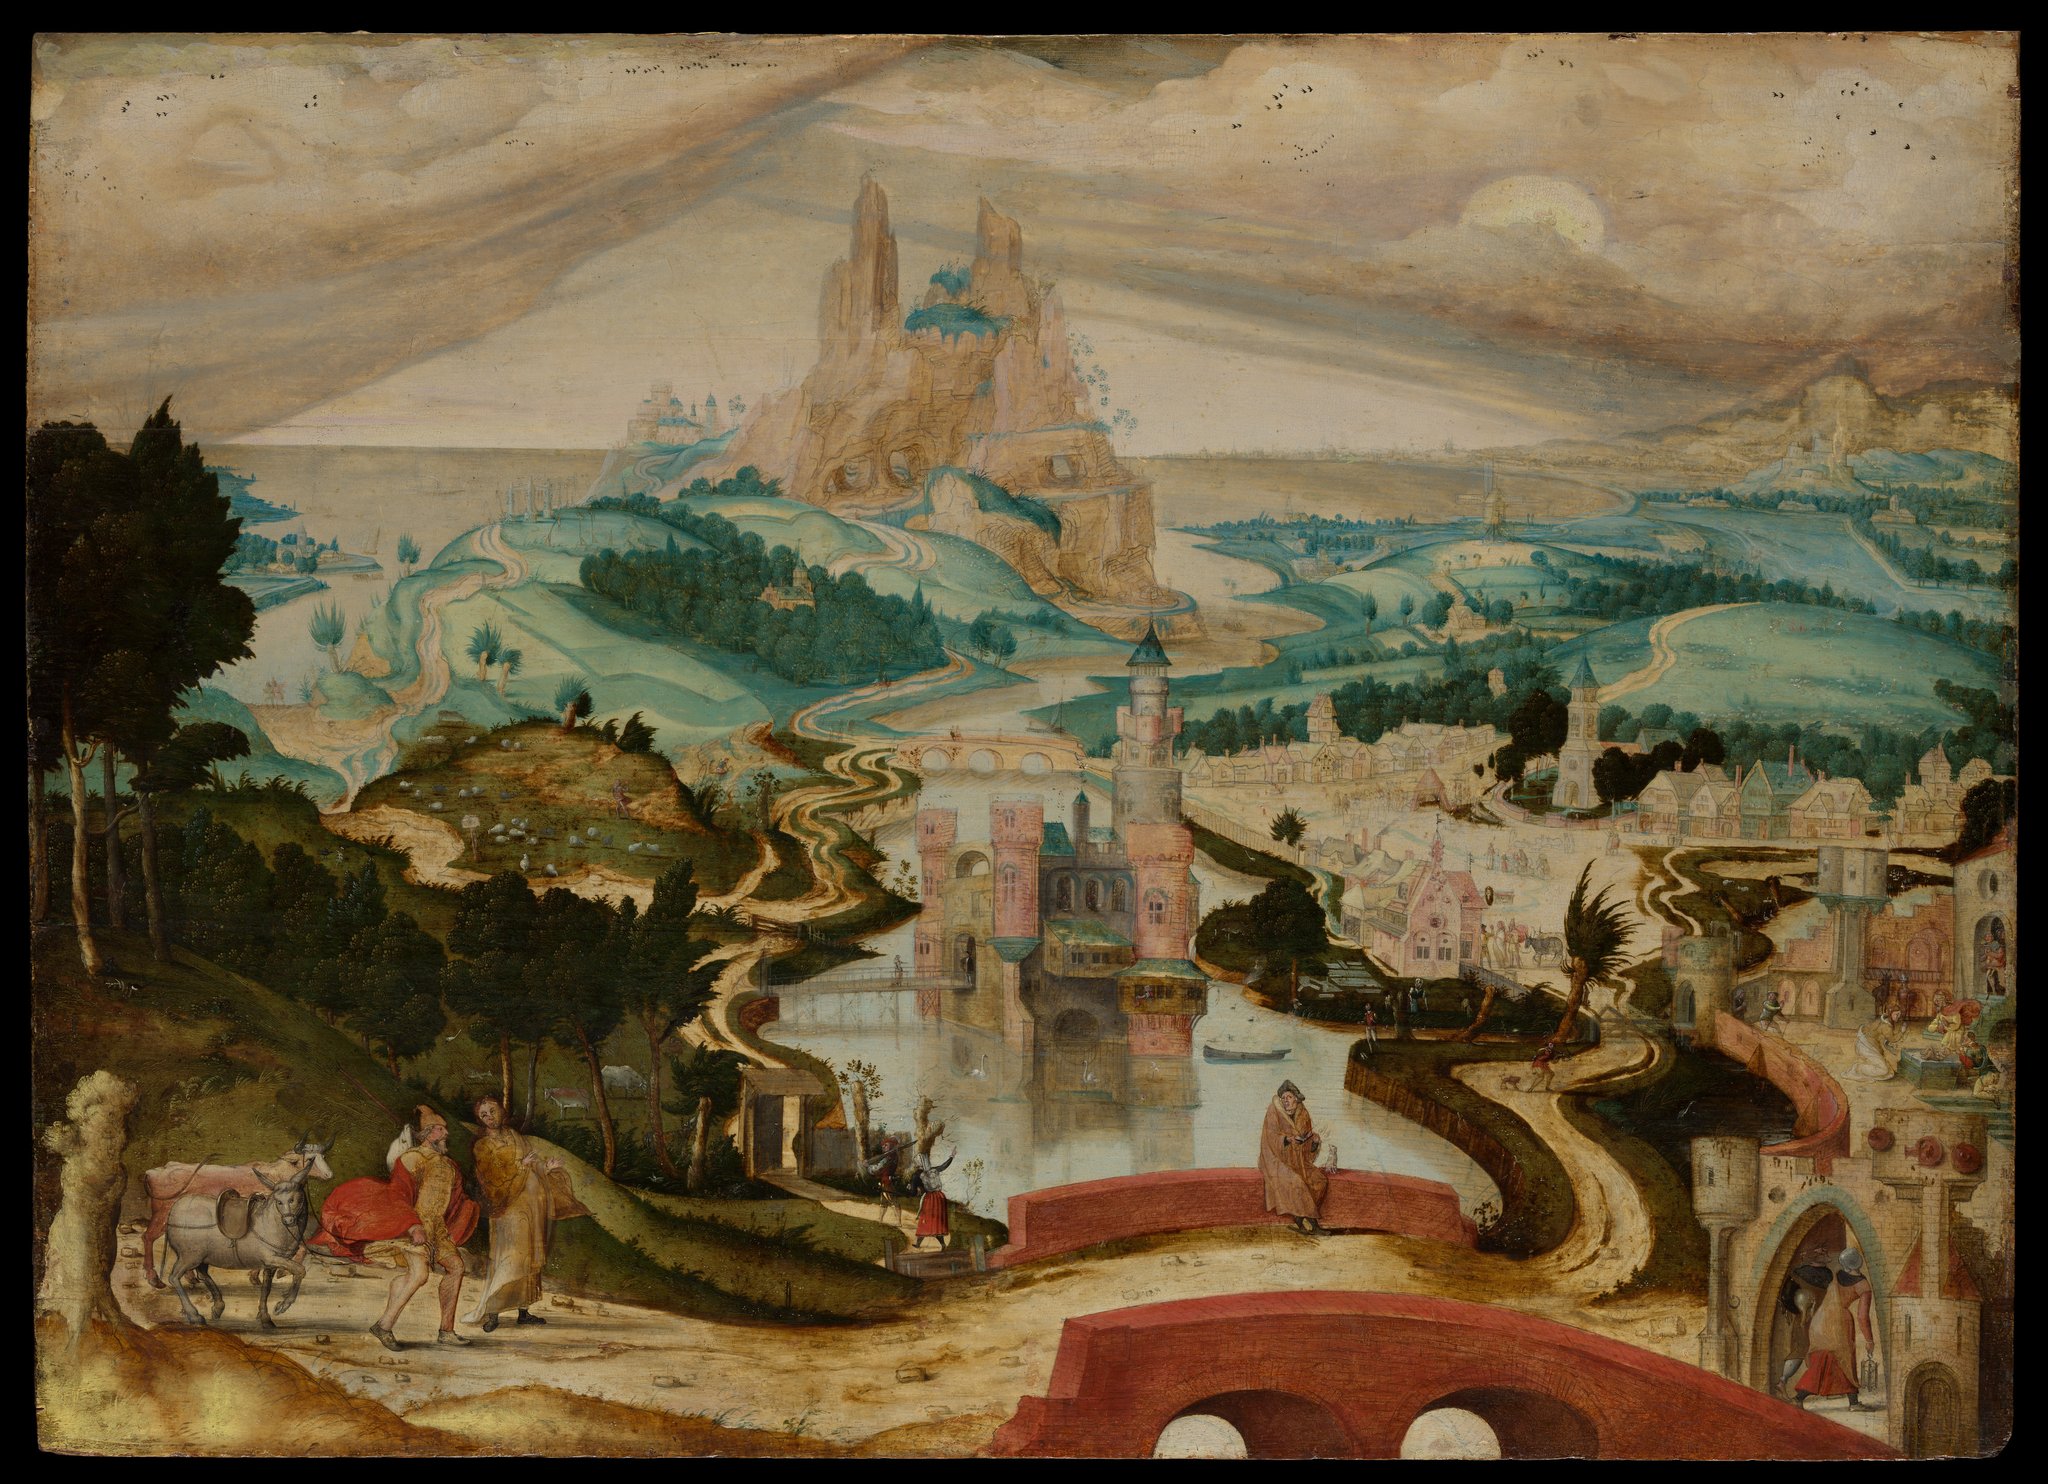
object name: painting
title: The Arrival in Bethlehem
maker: master of the brussels calling of saint matthew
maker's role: artist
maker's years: 1525-1549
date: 1540-1550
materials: oil, wood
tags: rivers,landscapes,saint joseph,virgin mary,jesus,nativity